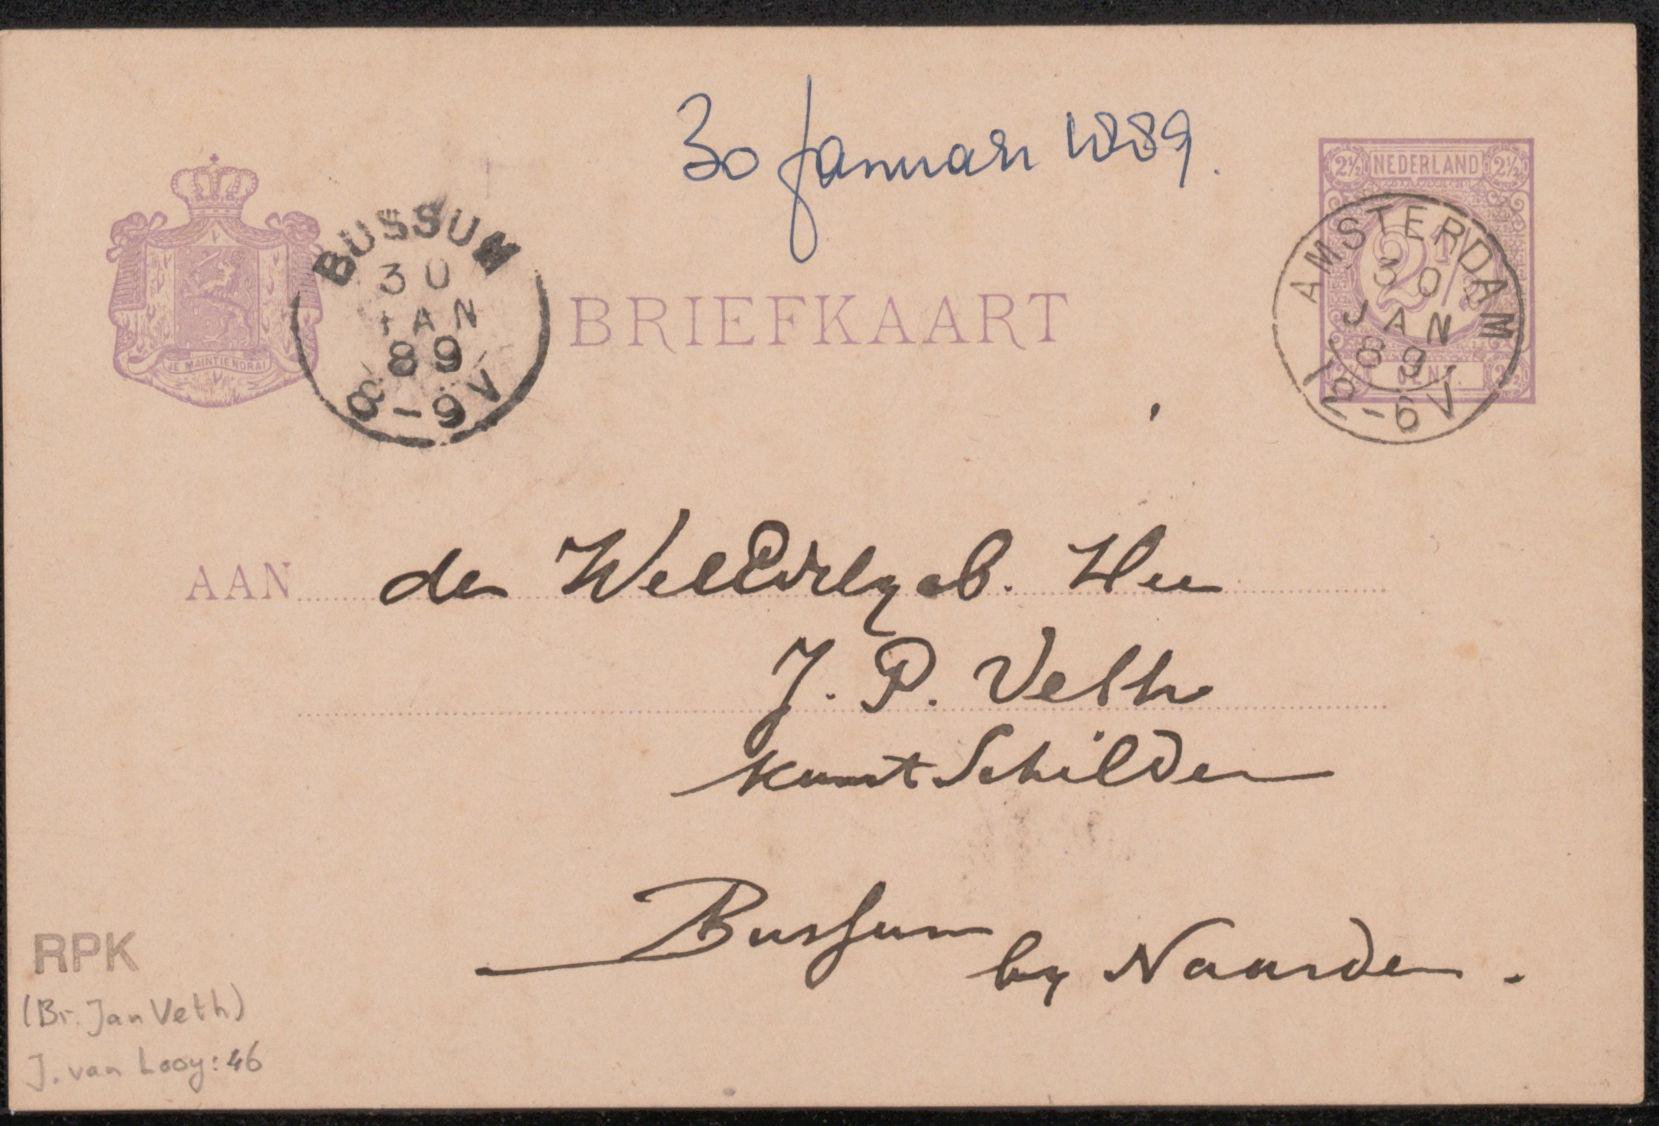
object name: postcard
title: Briefkaart aan Jan Veth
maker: jac van looij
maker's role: draughtsman, painter, print maker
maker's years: 1855-1930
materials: cardboard, ink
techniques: pen, writing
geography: amsterdam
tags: dordrecht, amsterdam, designer, jan veth, paris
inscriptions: collector's mark: ‘RPK’